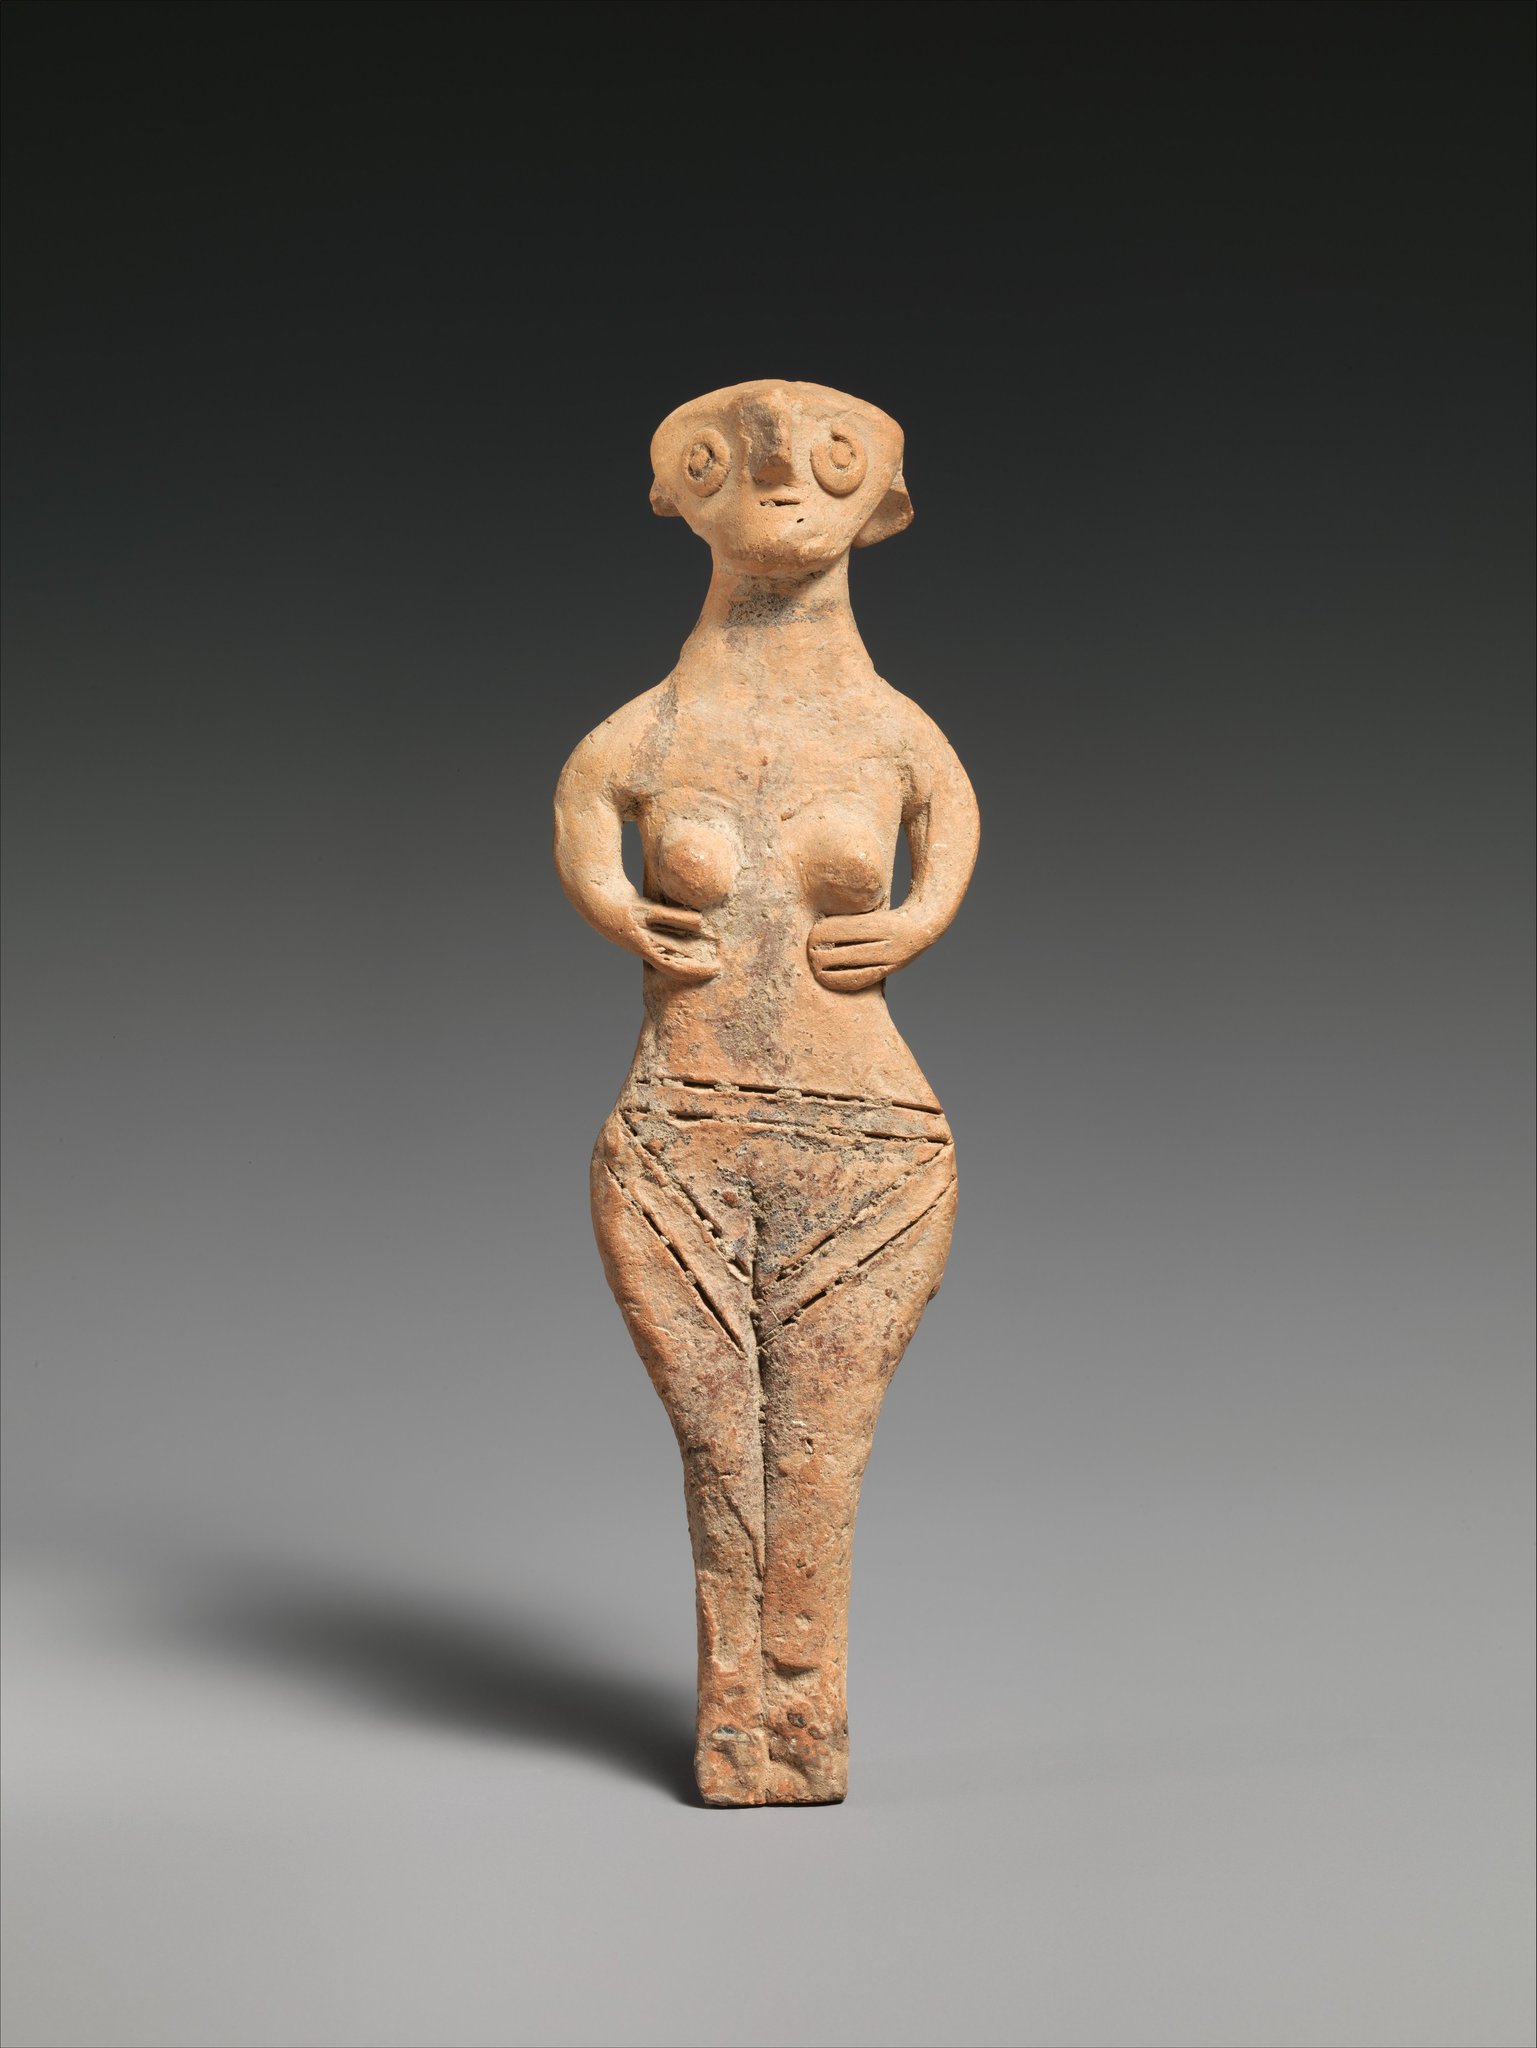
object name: statuette of a woman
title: Terracotta statuette of a nude woman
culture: cypriot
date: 1450-1200 BCE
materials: terracotta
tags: female nudes